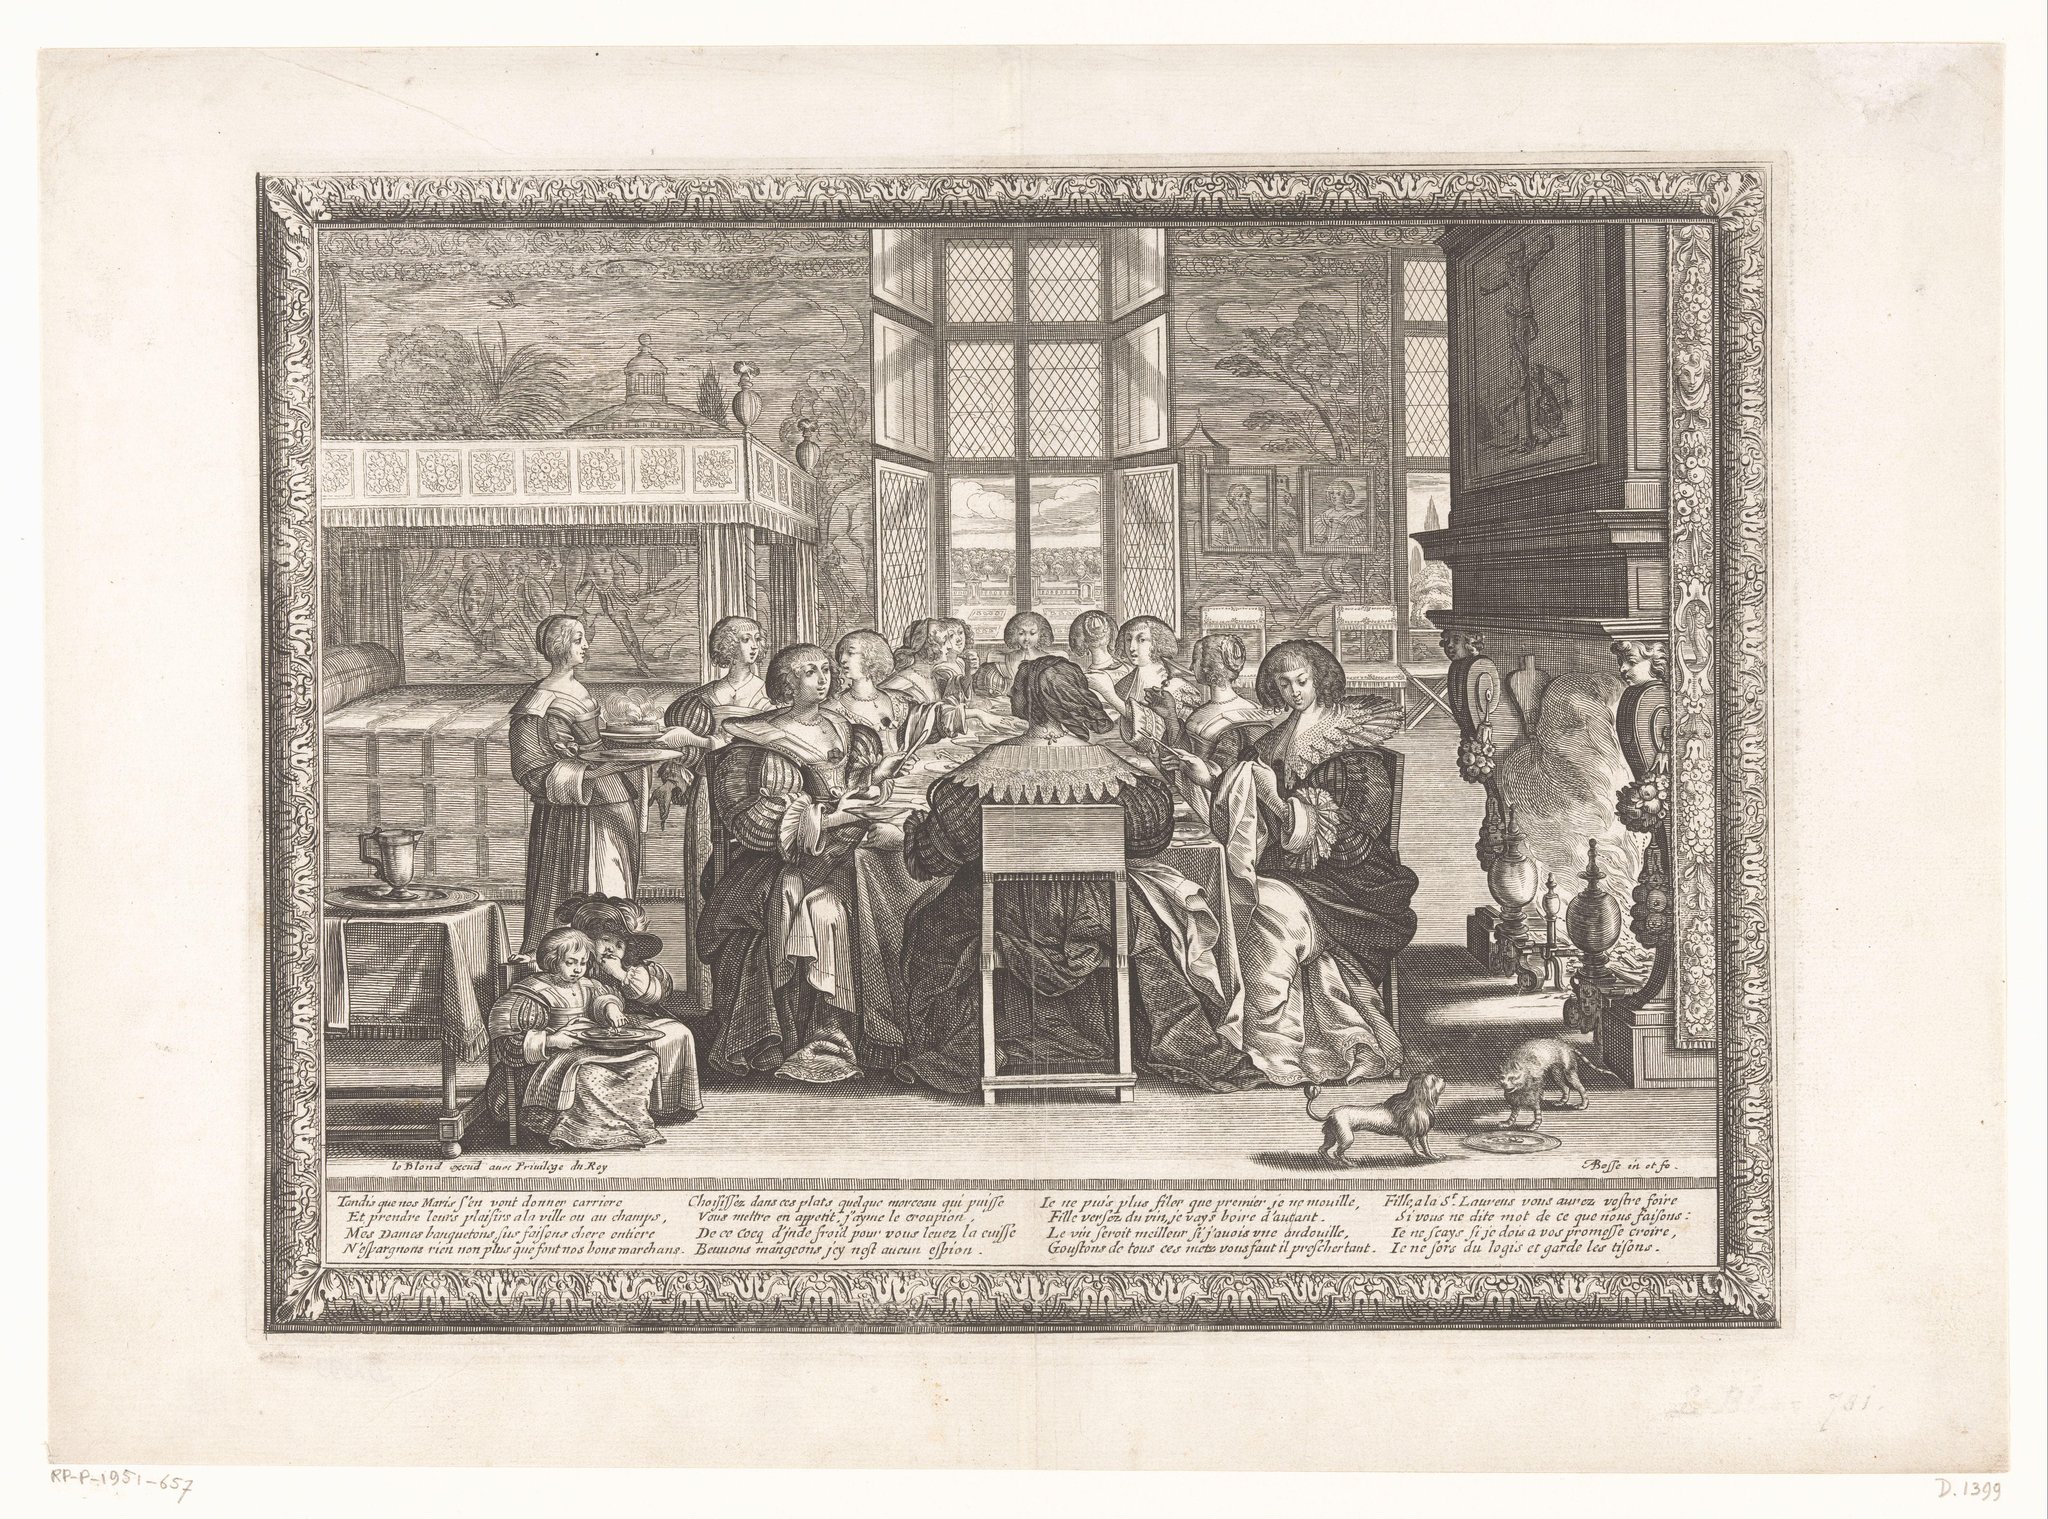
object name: print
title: Dinerende vrouwen aan een tafel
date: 1636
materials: paper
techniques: etching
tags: cat, dress, gown: dinner dress, evening meal, dinner, supper, dog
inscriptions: collector's mark: Lugt 2228